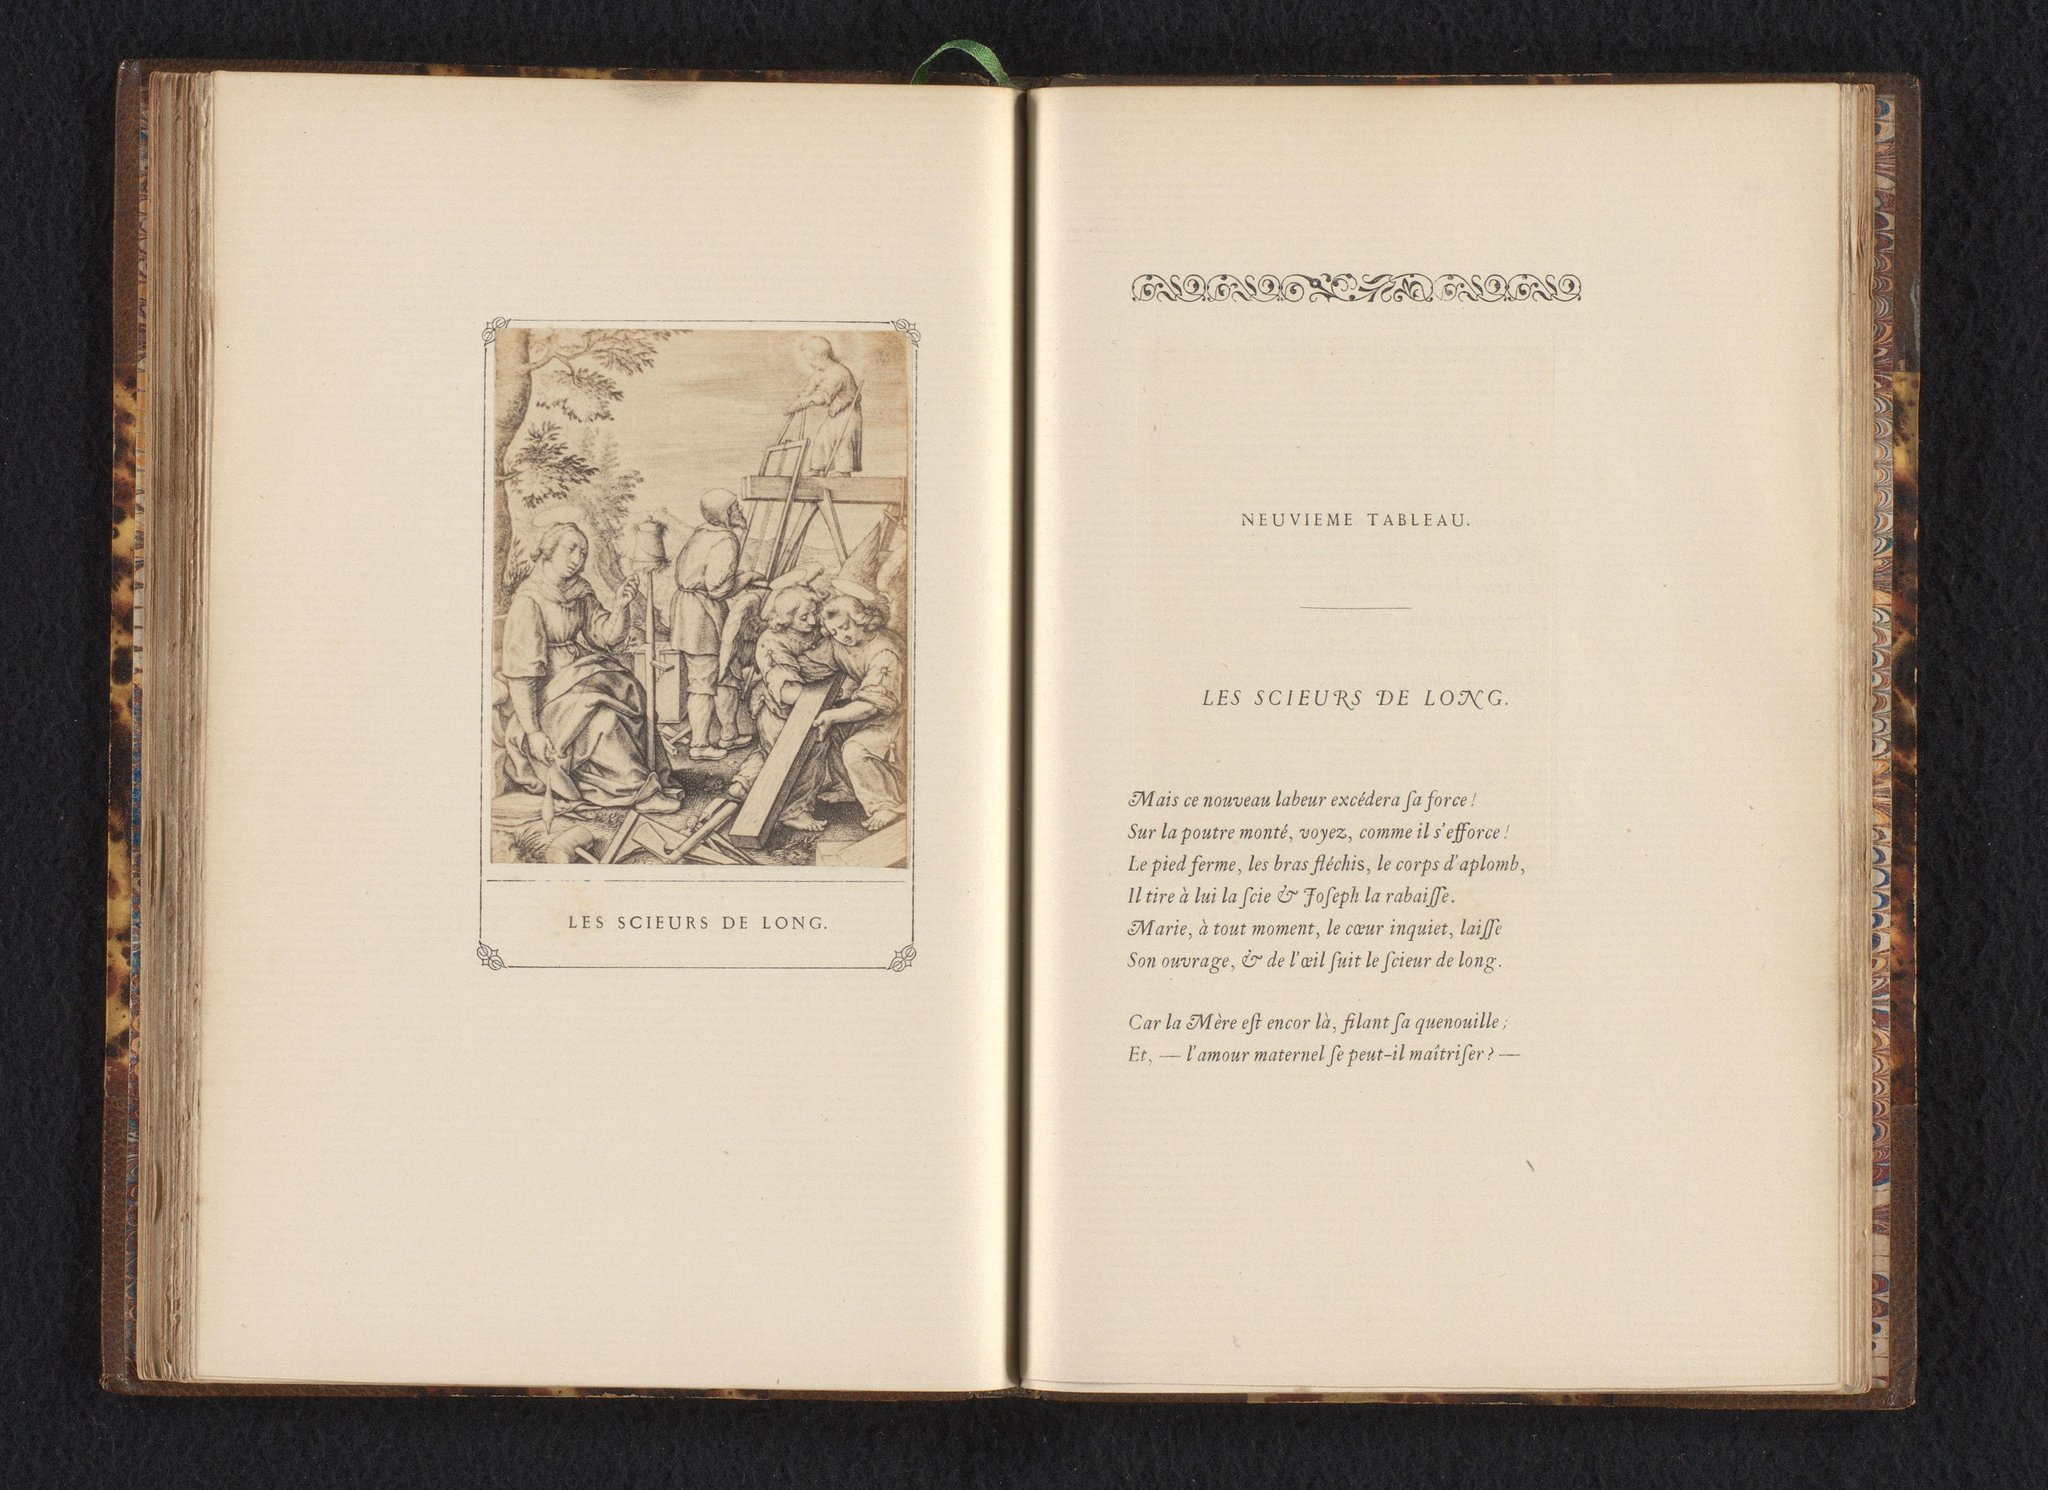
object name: reproduction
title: Fotoreproductie van de gravure Les scieurs de long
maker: edmond fierlants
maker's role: fotograaf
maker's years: 1819-1869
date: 1855-1860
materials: paper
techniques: albumen print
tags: angels, sawing (industrial process)